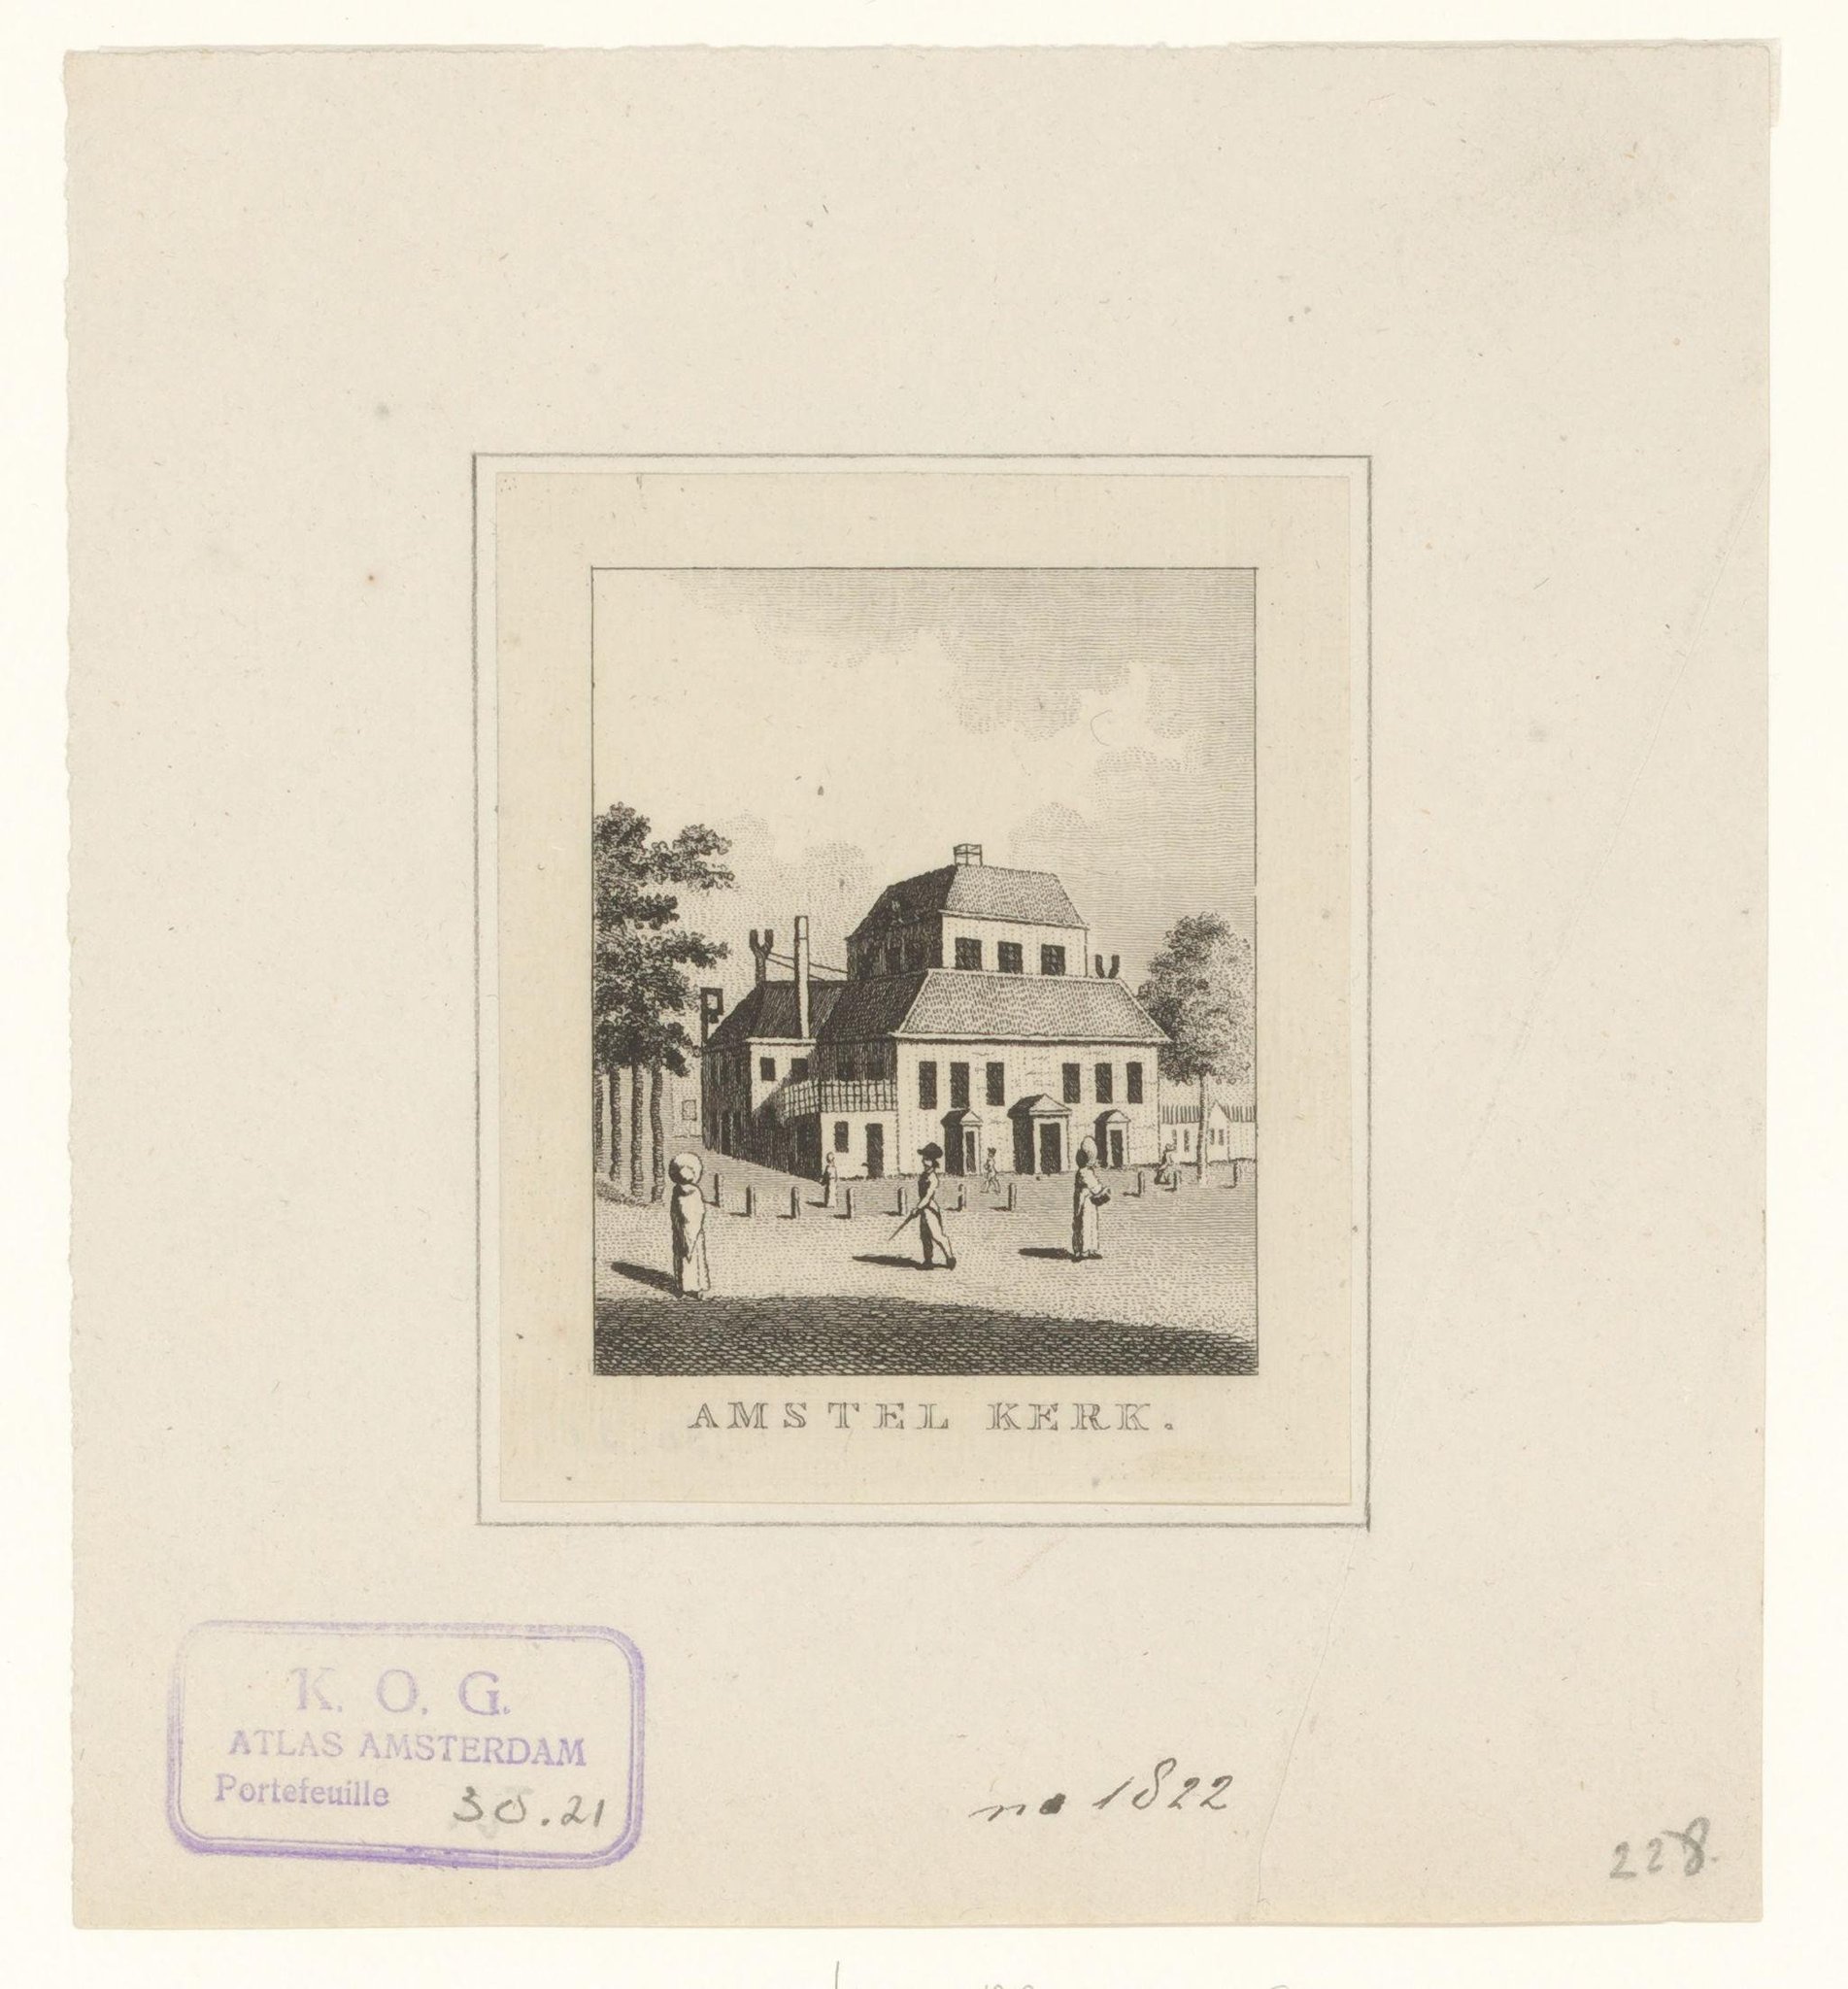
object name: print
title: Amstel Kerk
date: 1826-1847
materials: paper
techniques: engraving, etching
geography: netherlands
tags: church (exterior), city-view, and landscape with man-made constructions (+ city(-scape) with figures, staffage)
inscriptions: collector's mark: Lugt 1641b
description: Onderwerpsrubriek binnen de Atlas Amsterdam: Kerkwezen: Hervormde Gemeente: Amstelkerk.